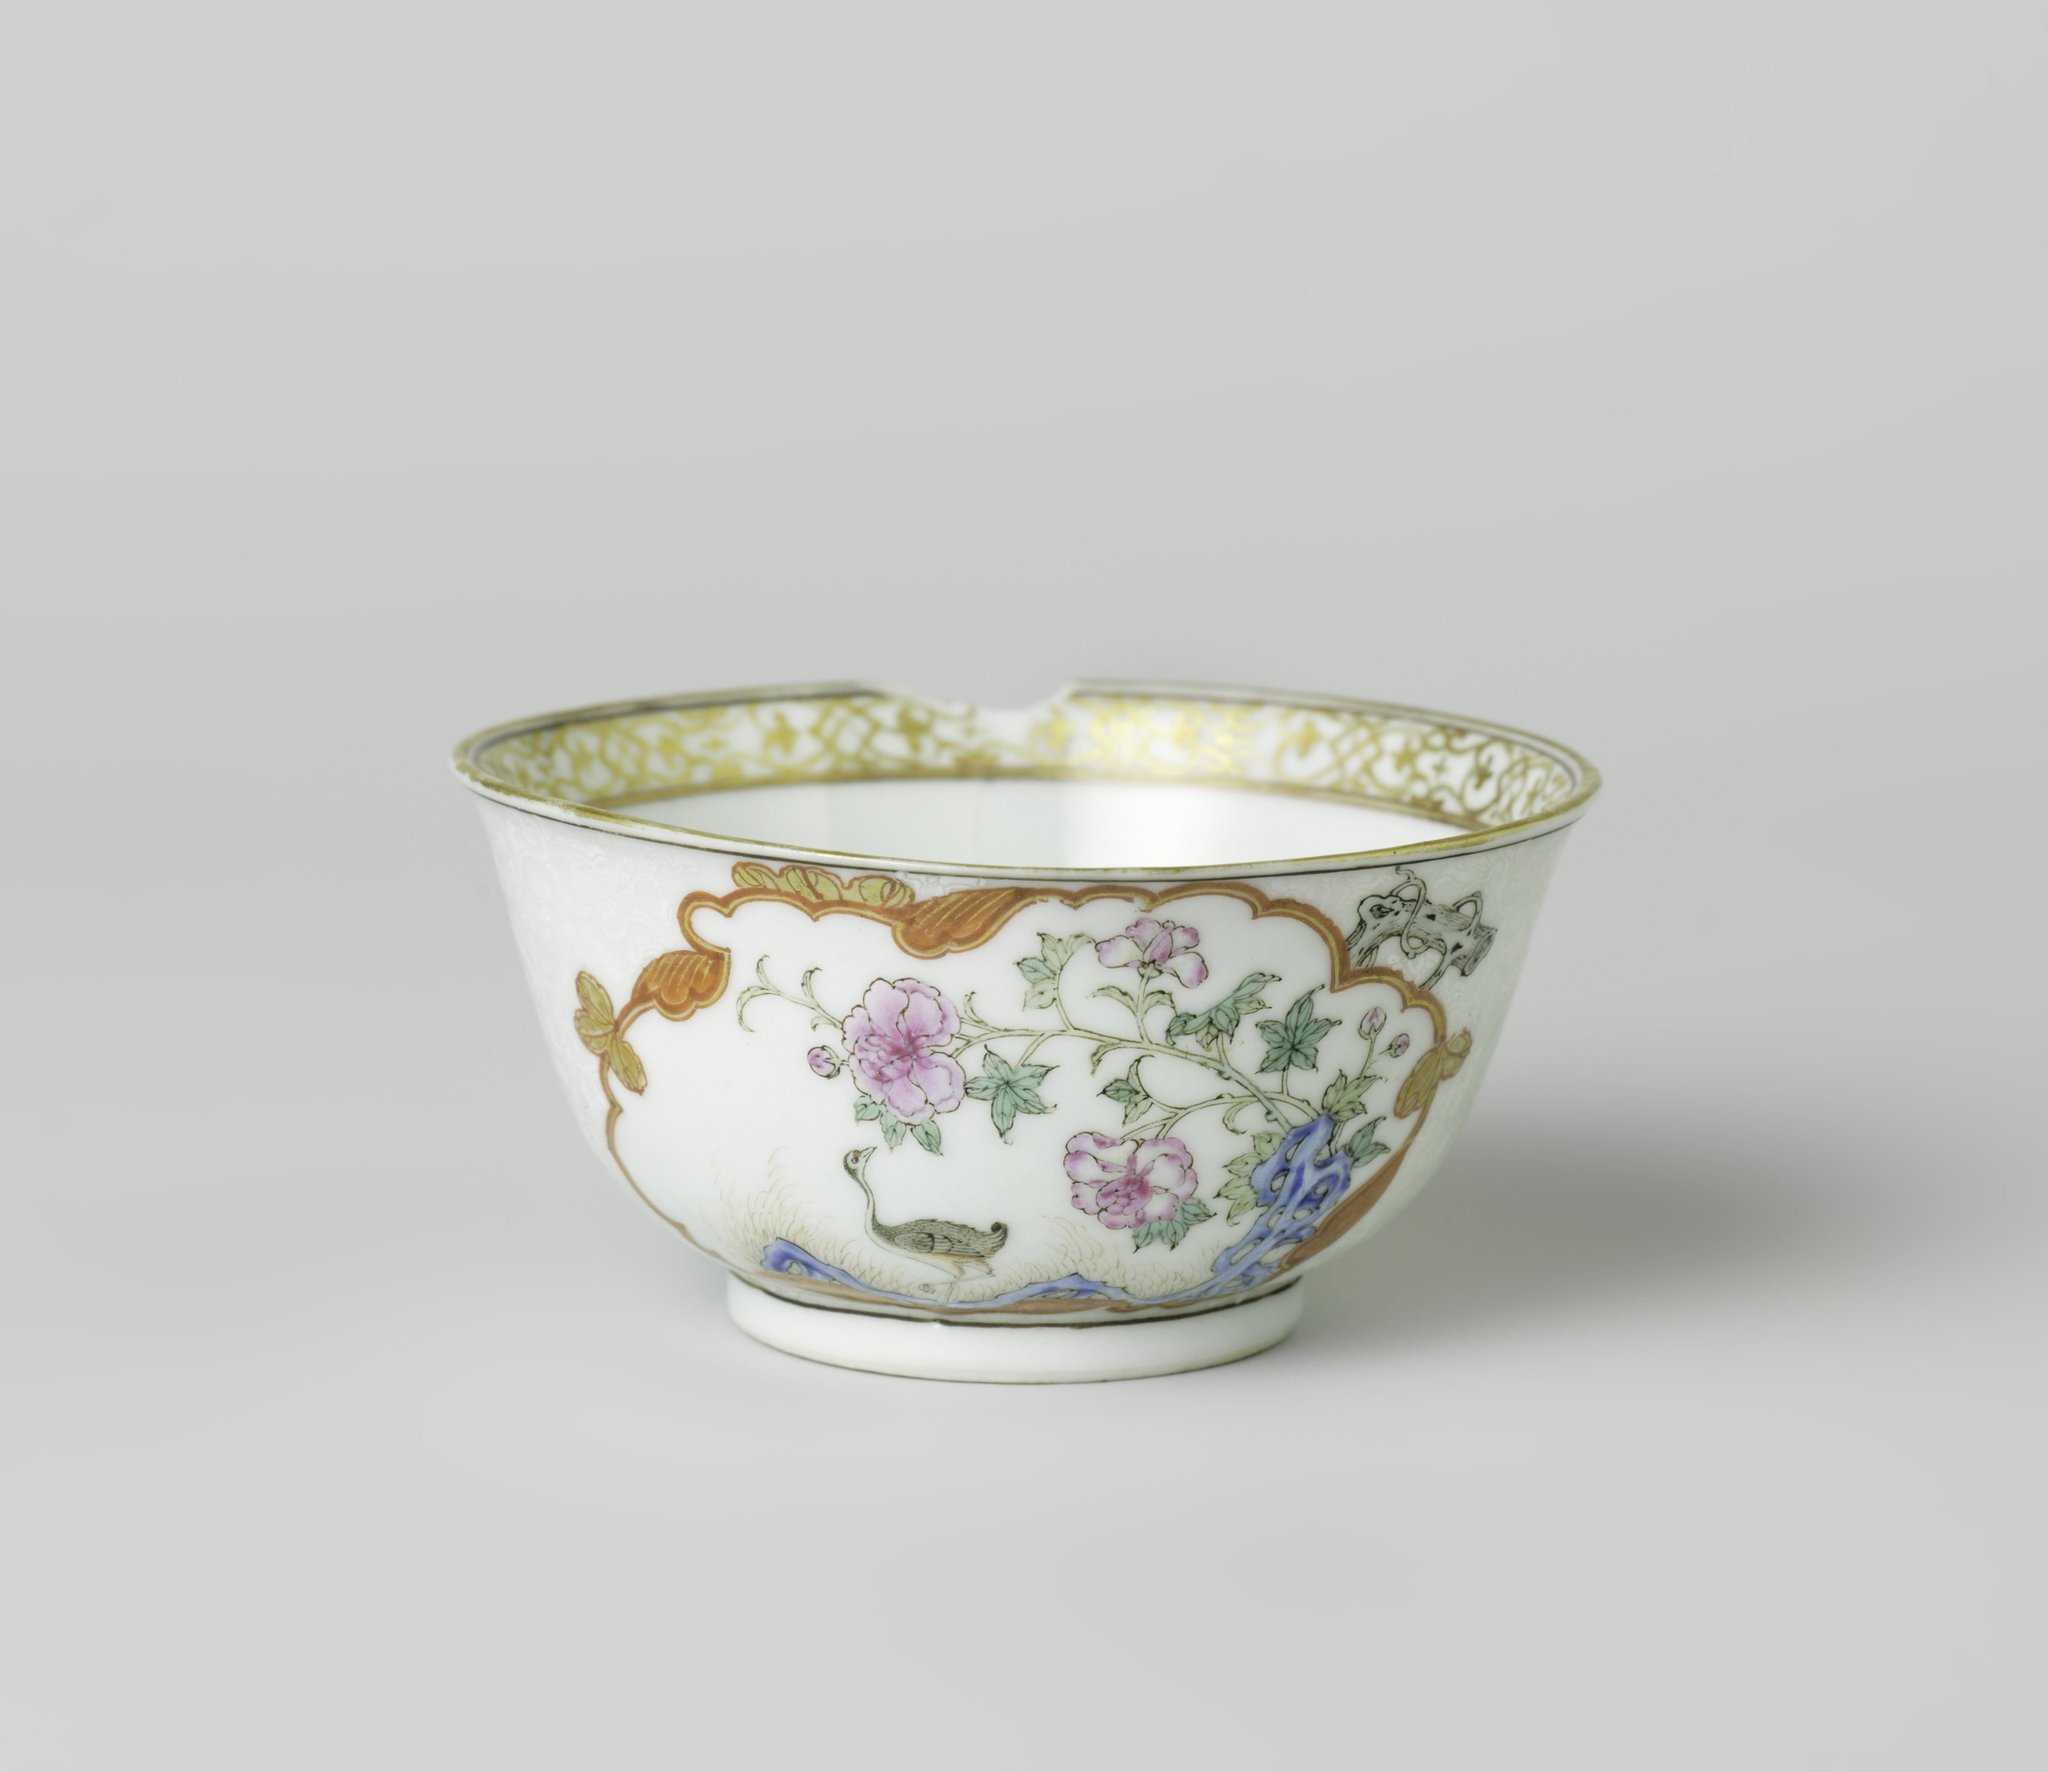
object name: cup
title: Bell-shaped cup with a crane near a peony plant and rock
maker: Anonymous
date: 1725-1749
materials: glaze, gold, paint, porcelain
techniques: firing, gilding, turning, vitrification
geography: china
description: Gedecoreerd in emails, goud en bianco sopra bianco met vogels en bloeiende planten.